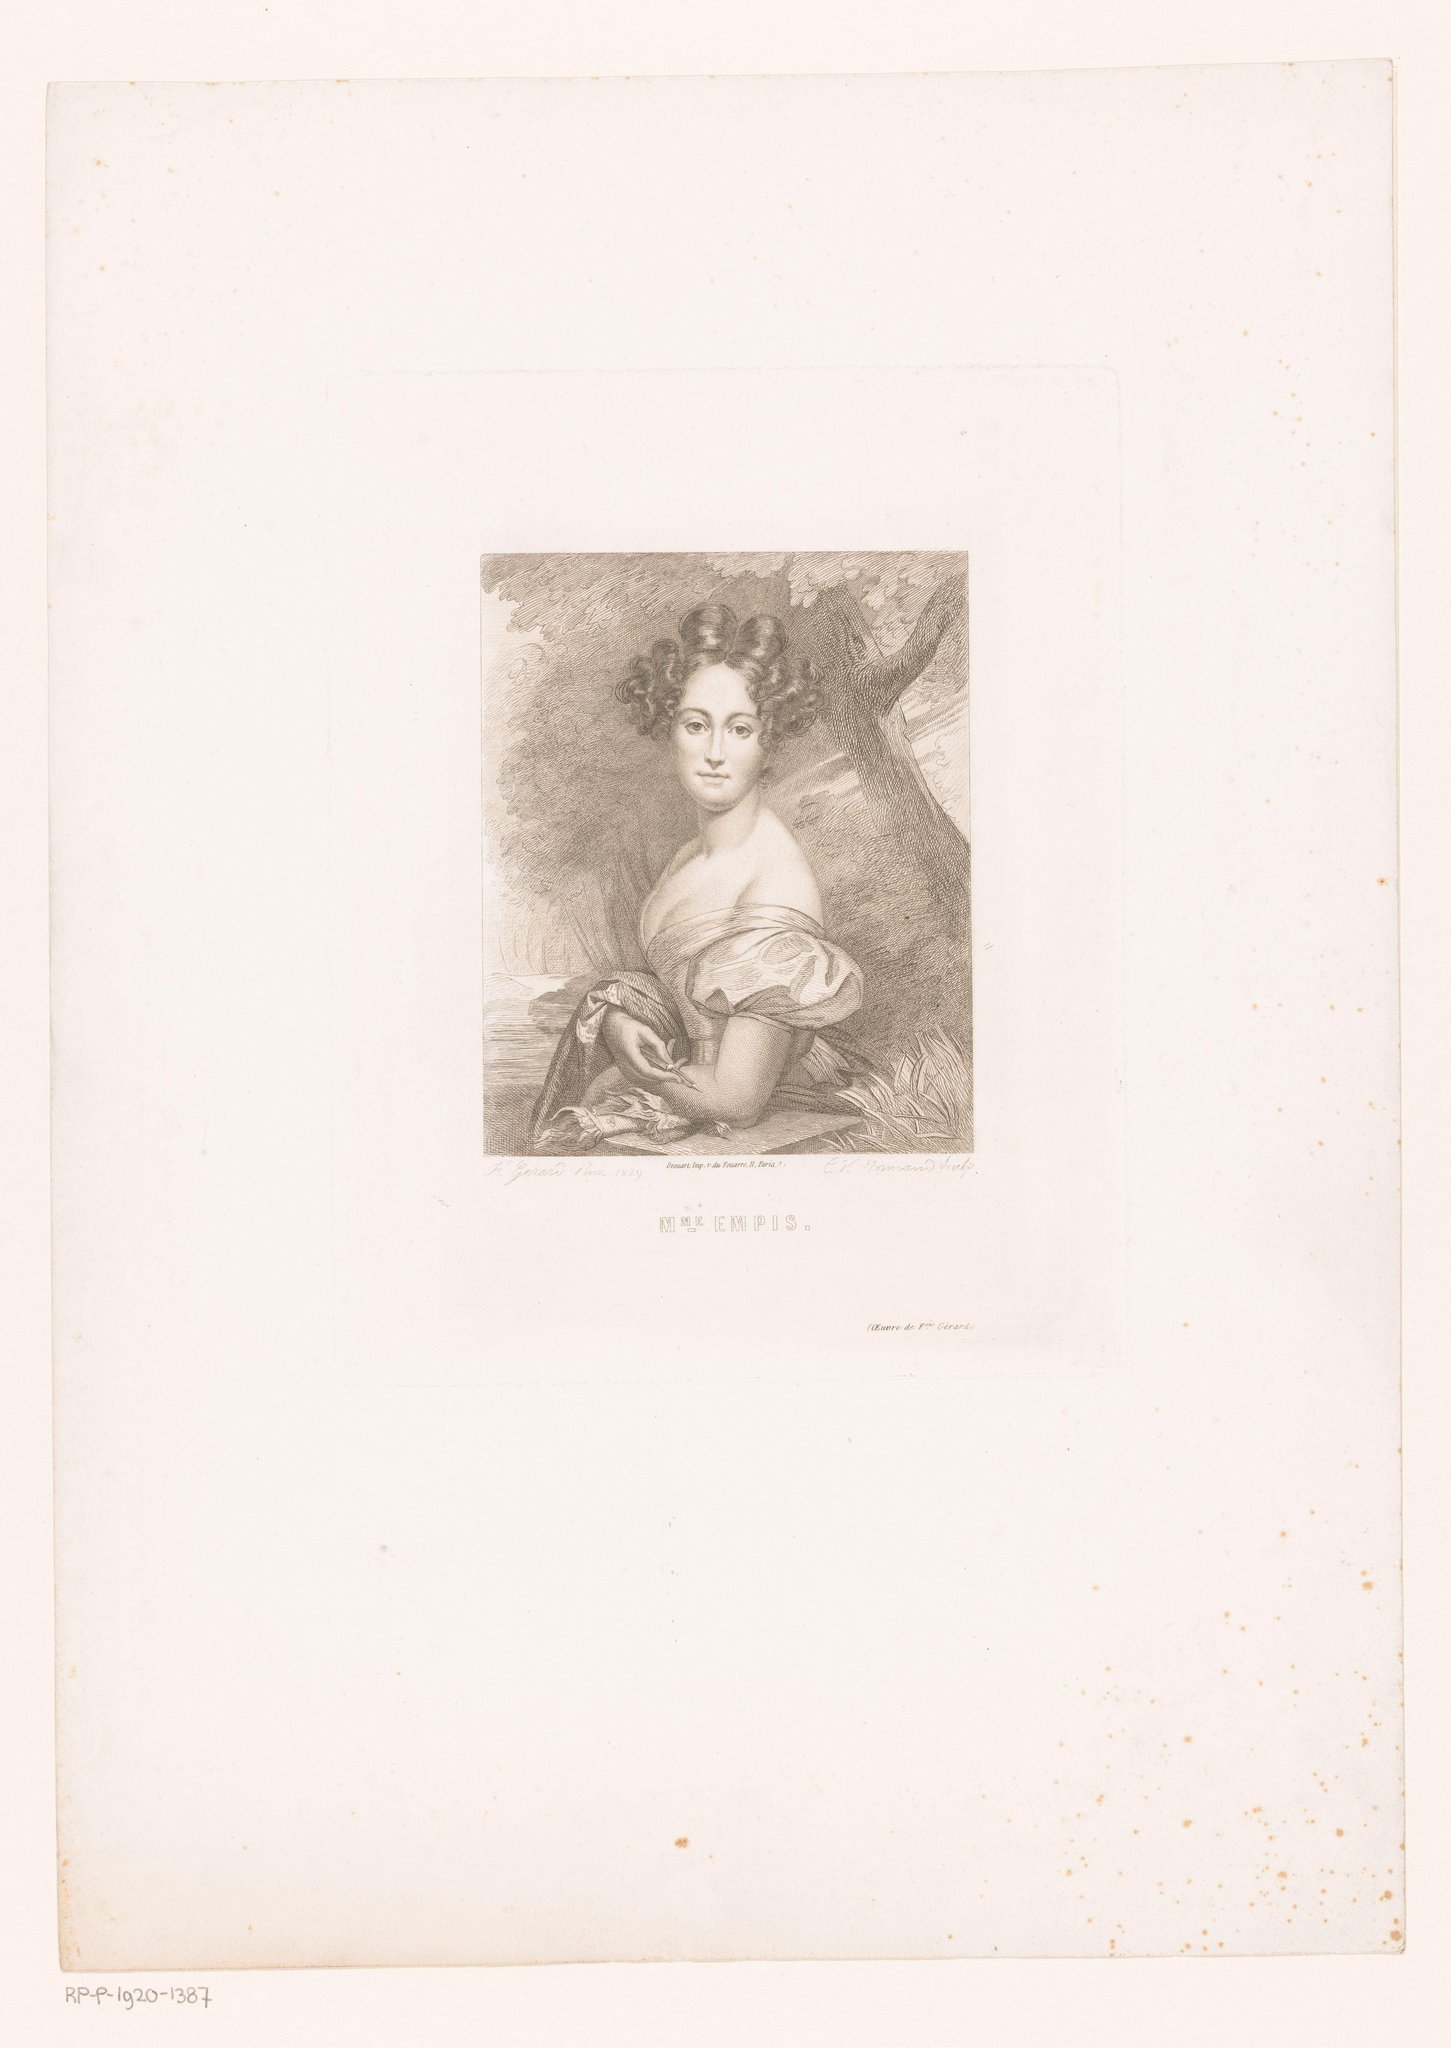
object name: print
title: Mme Empis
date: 1824-1920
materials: paper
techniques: etching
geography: paris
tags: paris, artist, historical persons - bb - woman, portrait, self-portrait of painter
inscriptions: collector's mark: Lugt 2228, check stamp: Lugt 4336